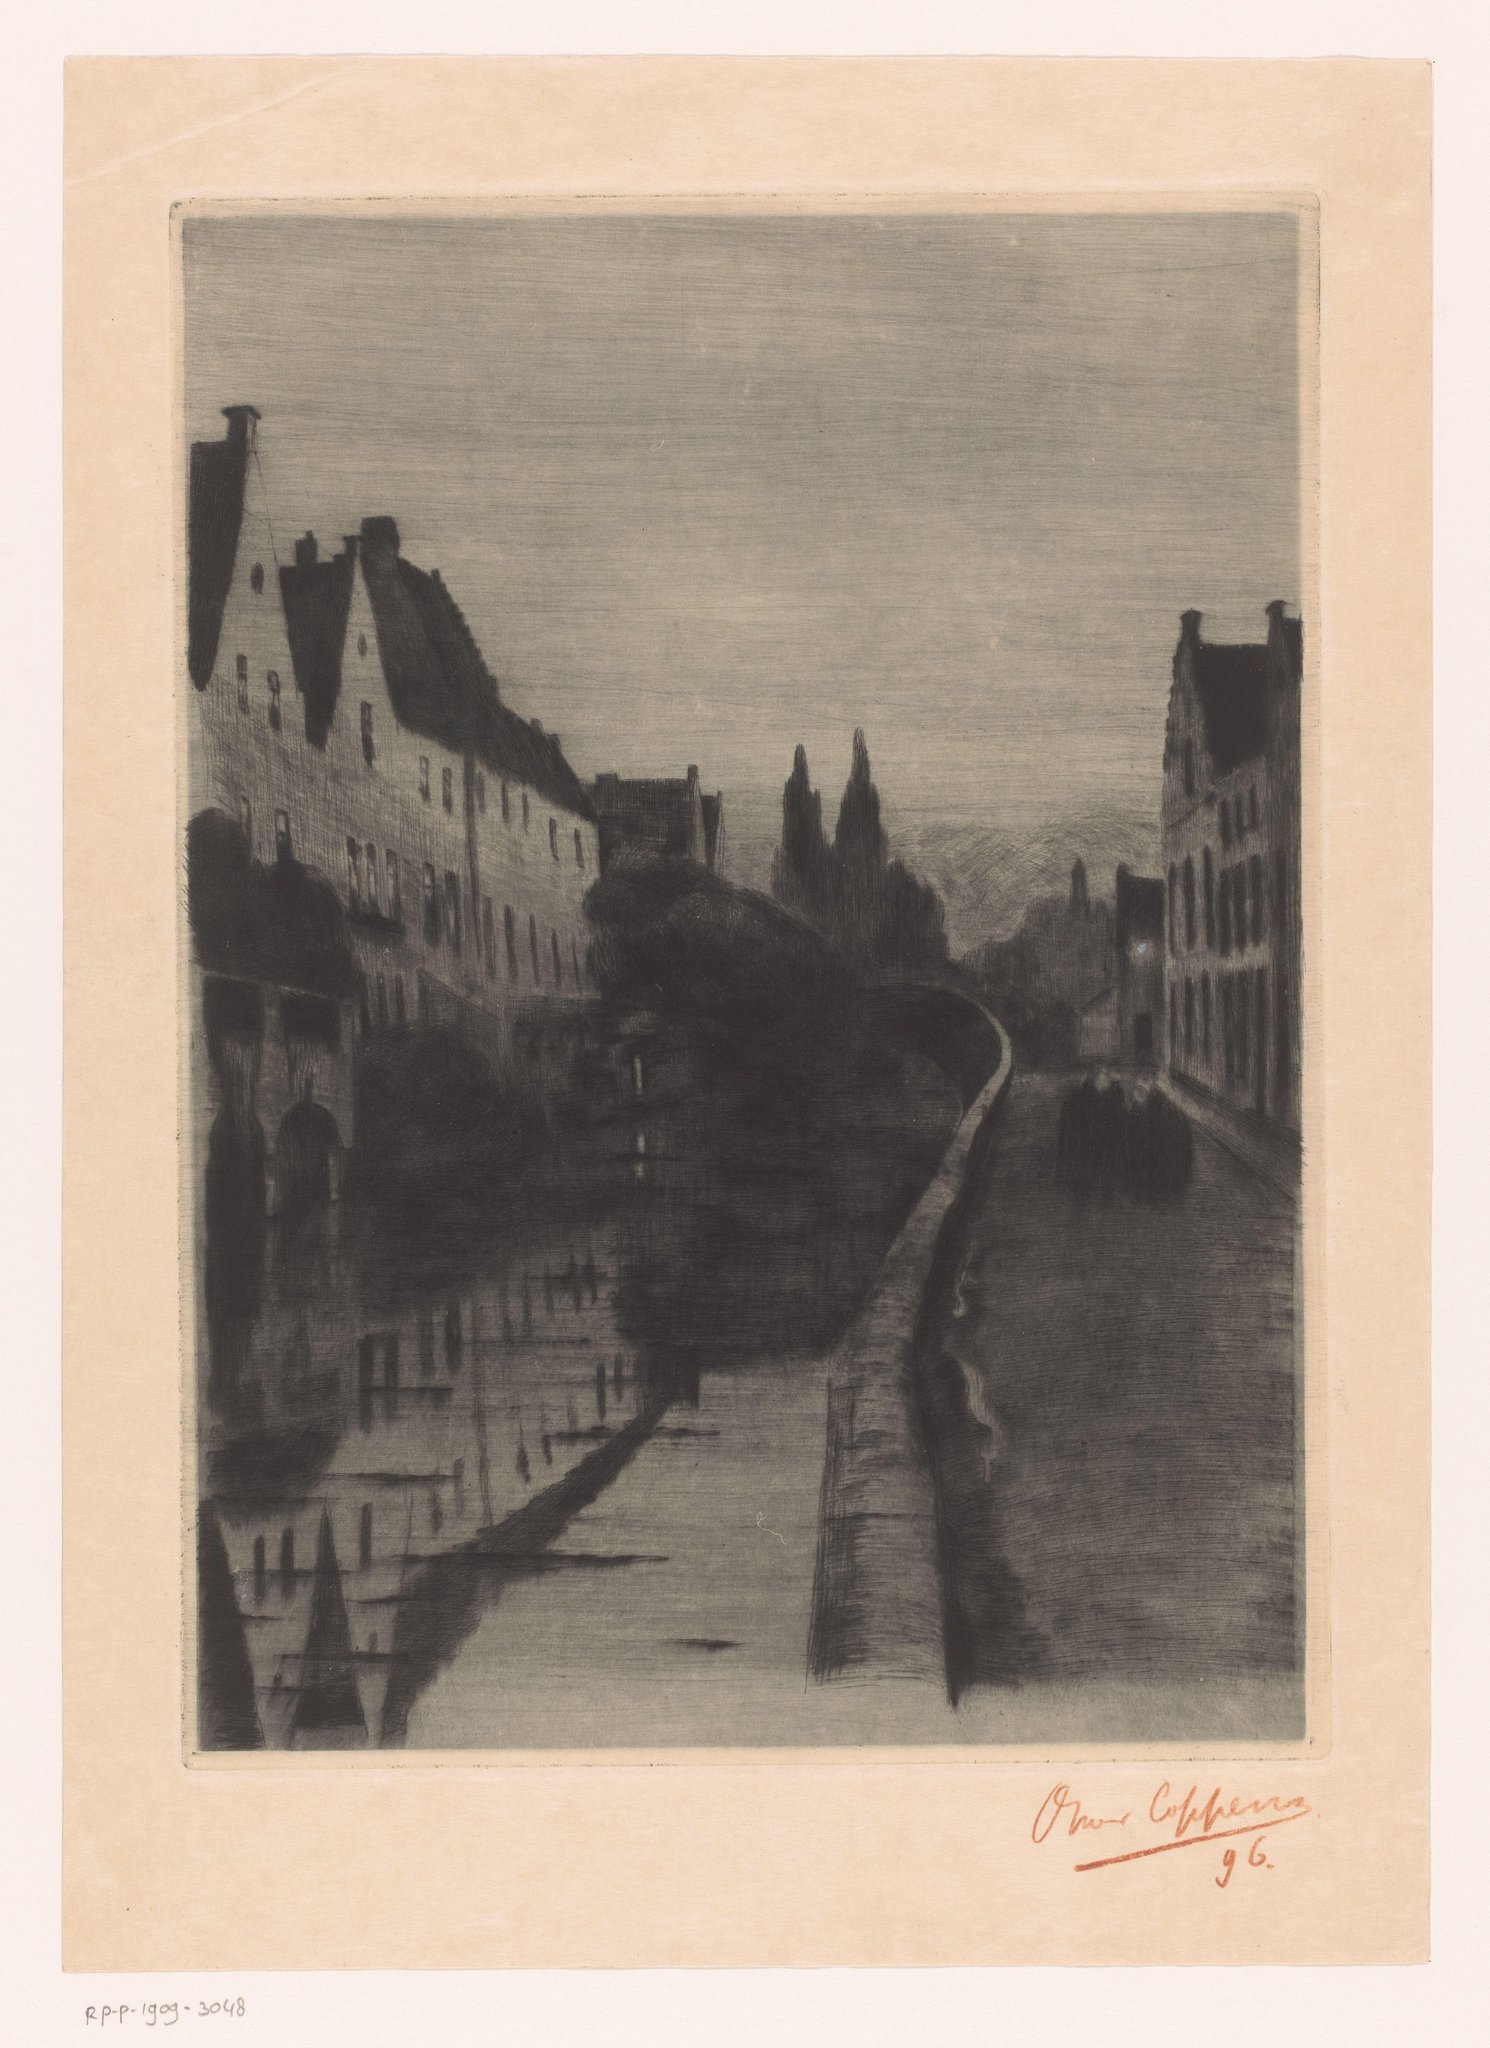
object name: print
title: Twee figuren lopen langs een stadsgracht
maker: omer coppens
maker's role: print maker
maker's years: 1864-1926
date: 1896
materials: paper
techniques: drypoint, etching, intaglio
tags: canals, waters (in city), street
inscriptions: collector's mark: Lugt 2228